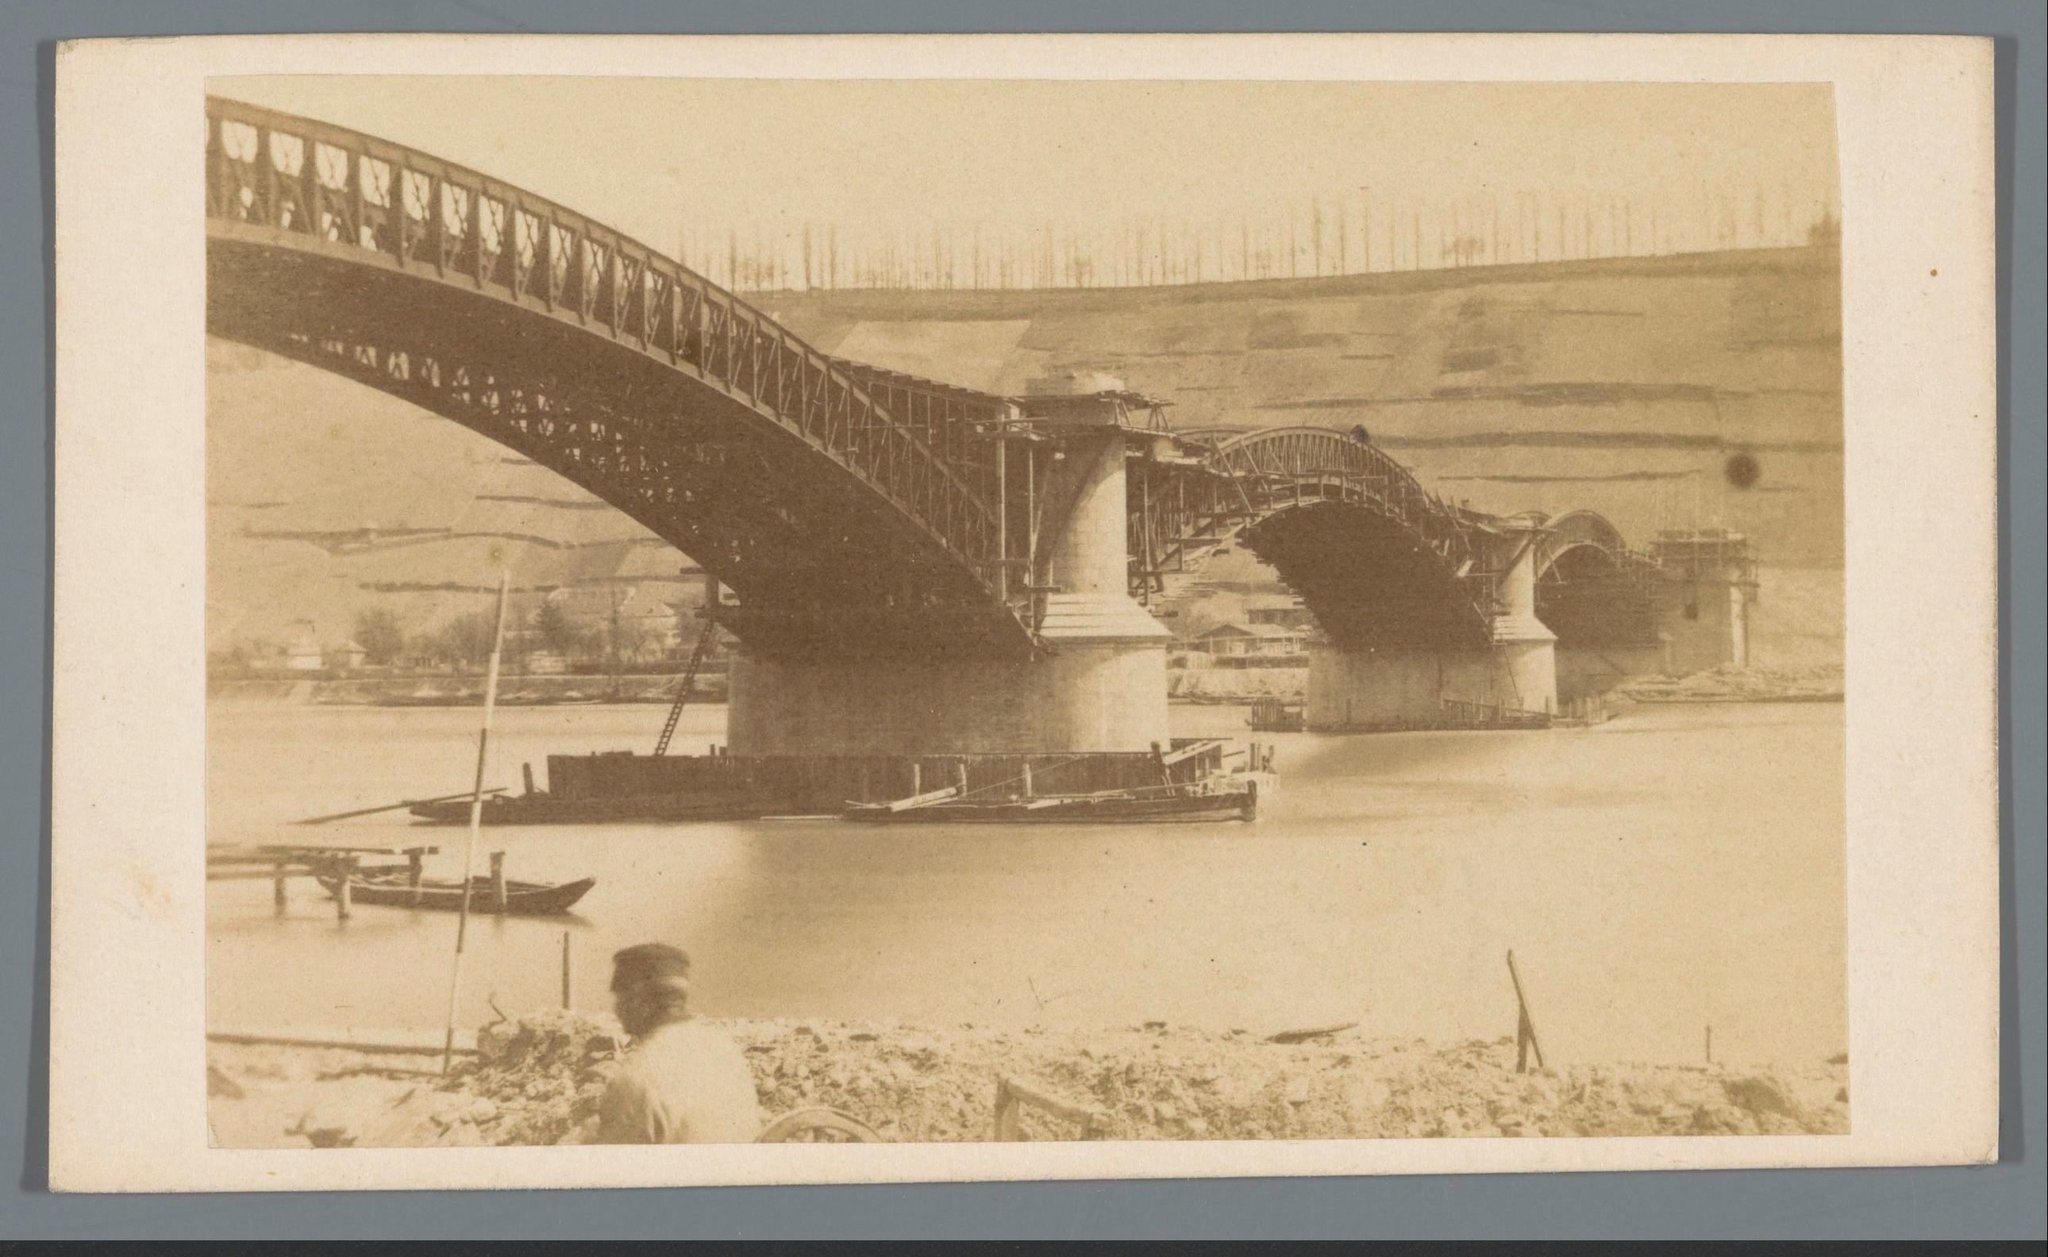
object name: photograph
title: Nieuwe Rijnbrug bij Koblenz, Duitsland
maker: Anonymous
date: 1860-1875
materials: cardboard, paper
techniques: albumen print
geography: koblenz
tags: bridge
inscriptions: inscription: ‘ZE cr’